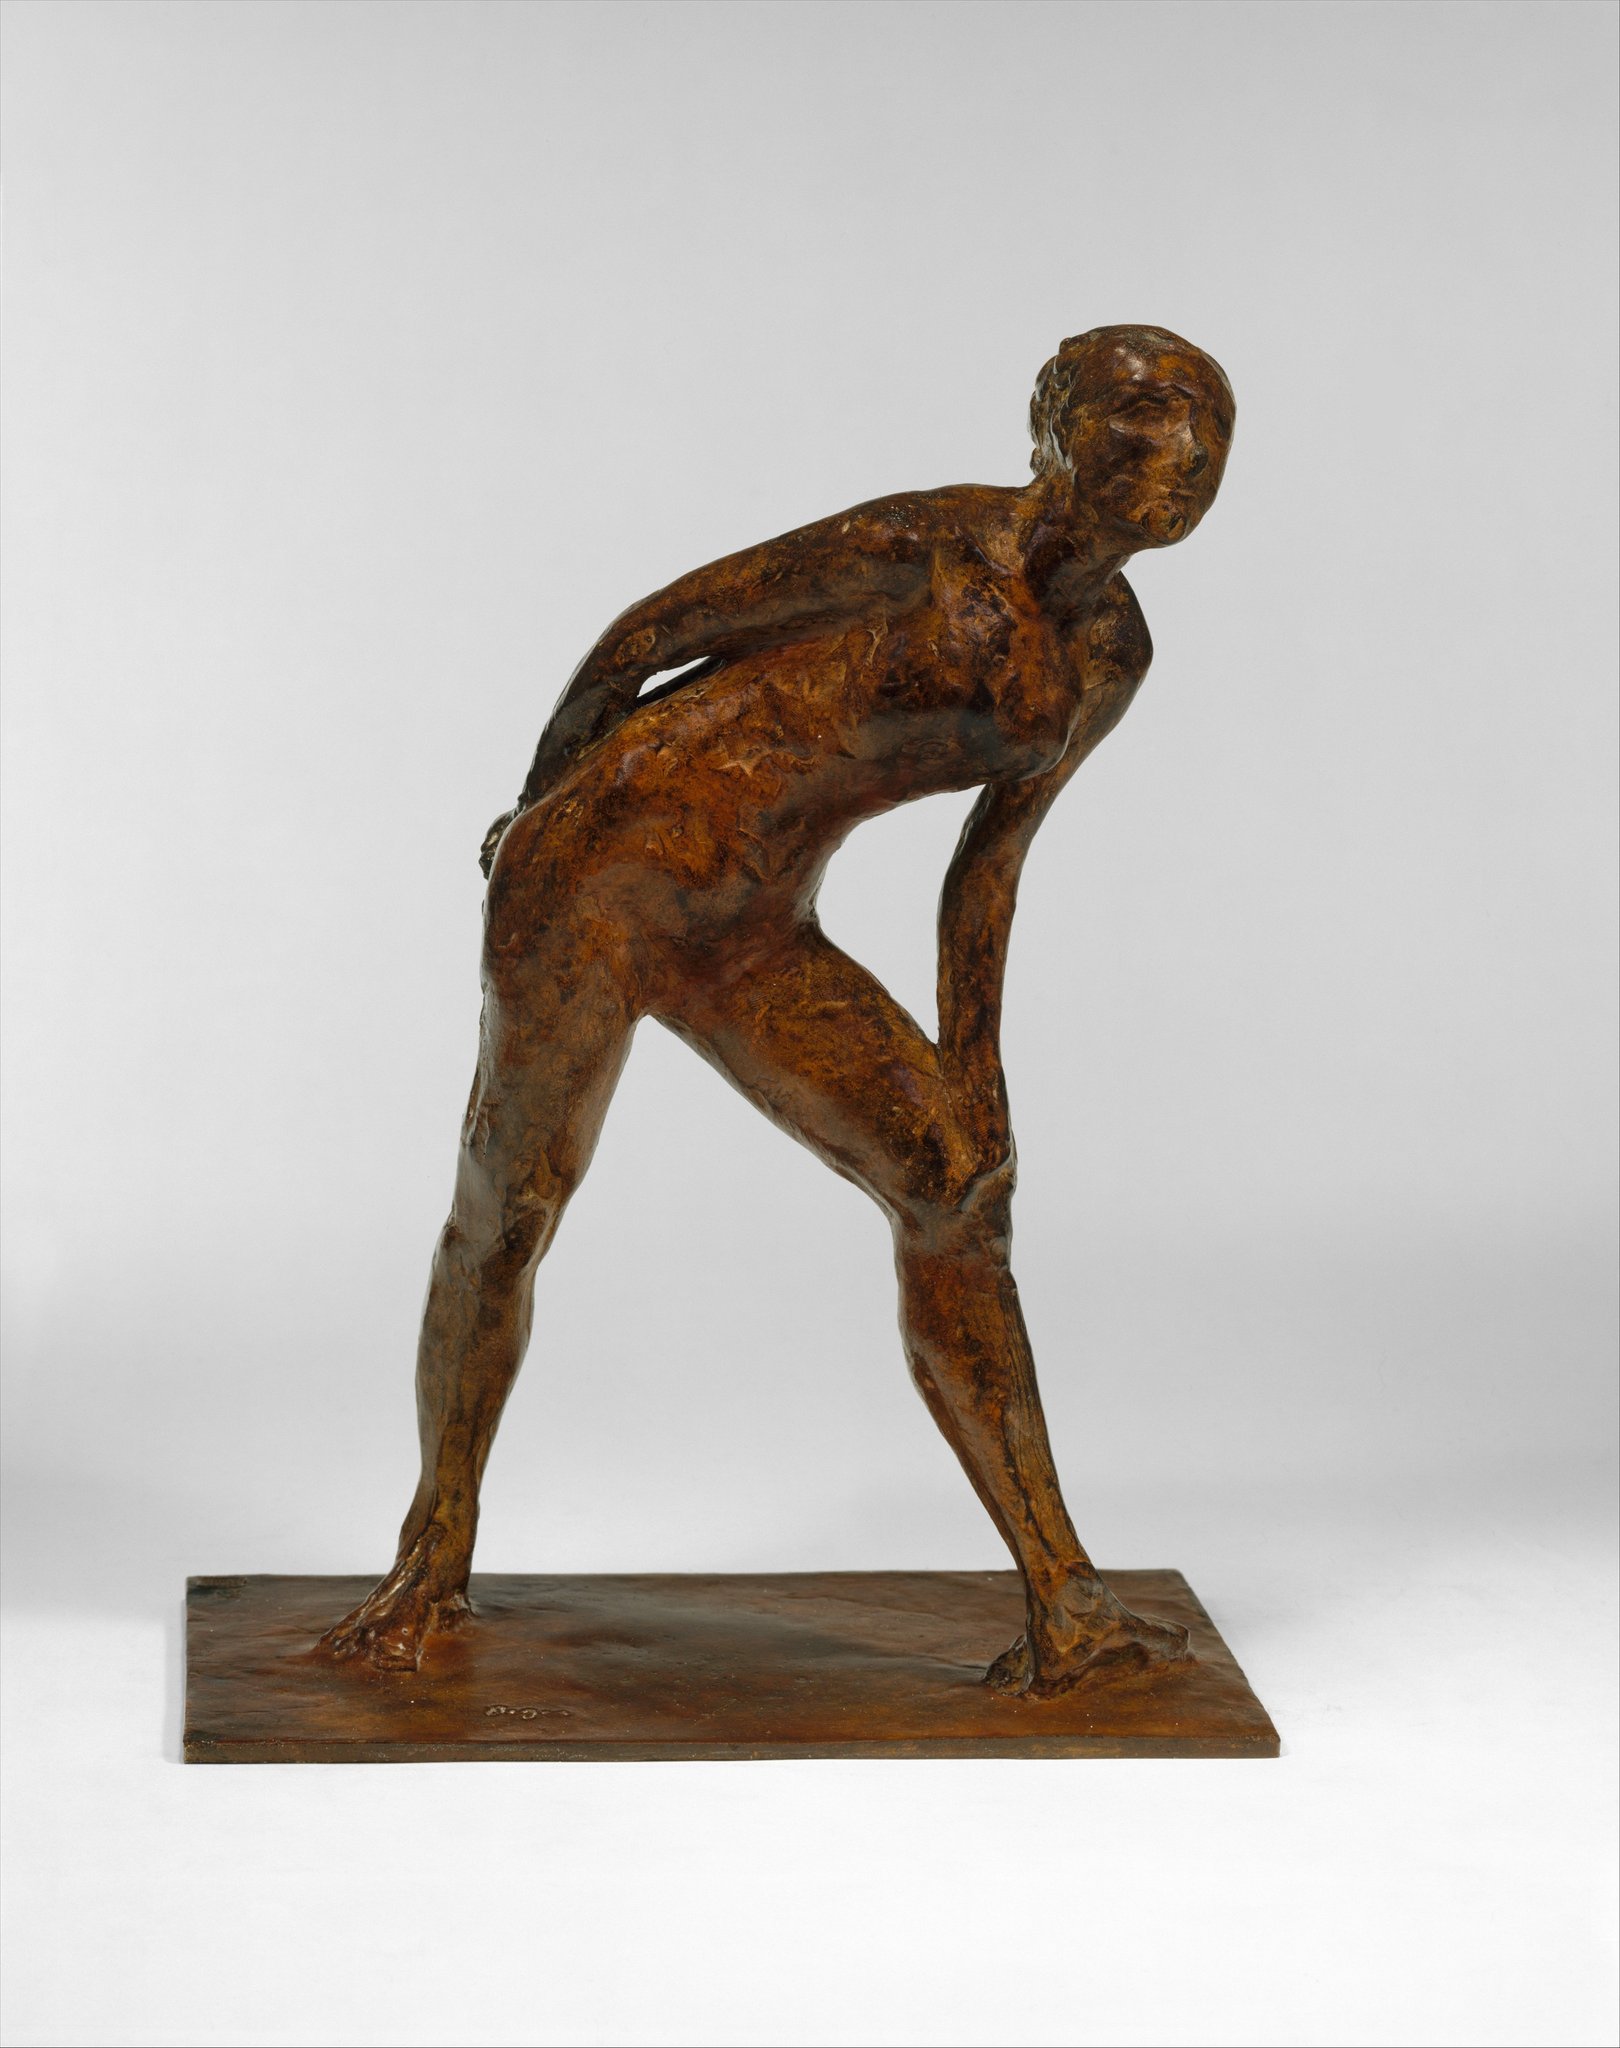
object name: statuette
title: Dancer in the Role of Harlequin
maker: edgar degas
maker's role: artist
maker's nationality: french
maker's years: 1834-1917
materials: bronze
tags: female nudes,dancers